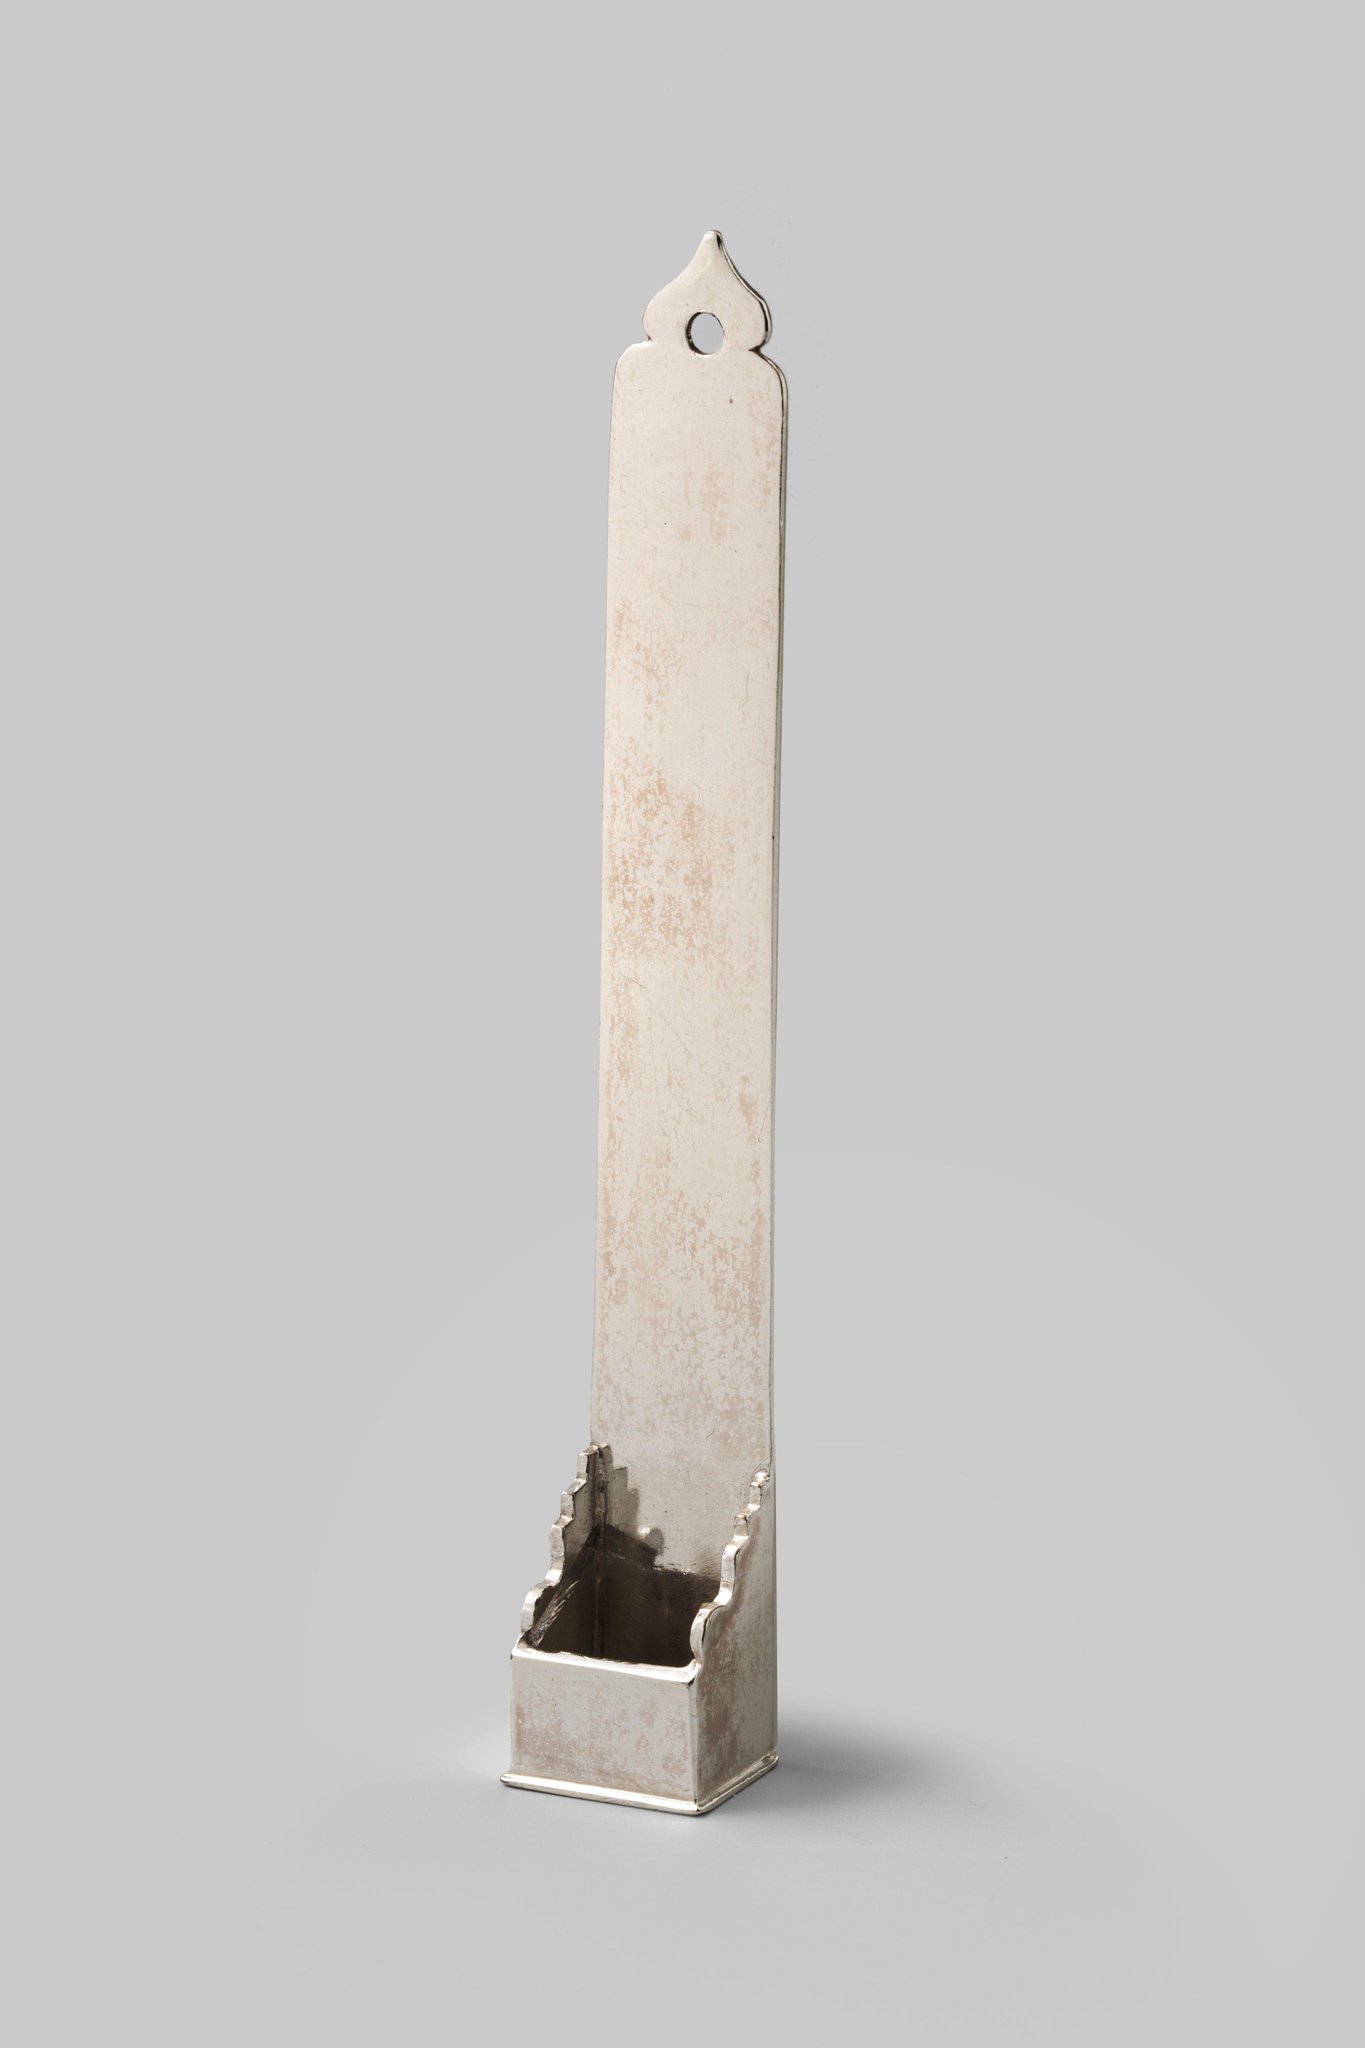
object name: miniature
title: Schuurplank van zilver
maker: frederik van strant (i)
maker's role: silversmith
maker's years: 1678-1727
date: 1706-1727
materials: silver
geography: amsterdam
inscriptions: town mark: ‘kleine stadskeur Amsterdam’, maker's mark: ‘FS (Citroen 1975, nr. 231)’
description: Schuurplank van zilver met zandbakje, onversierd, met draagoog.